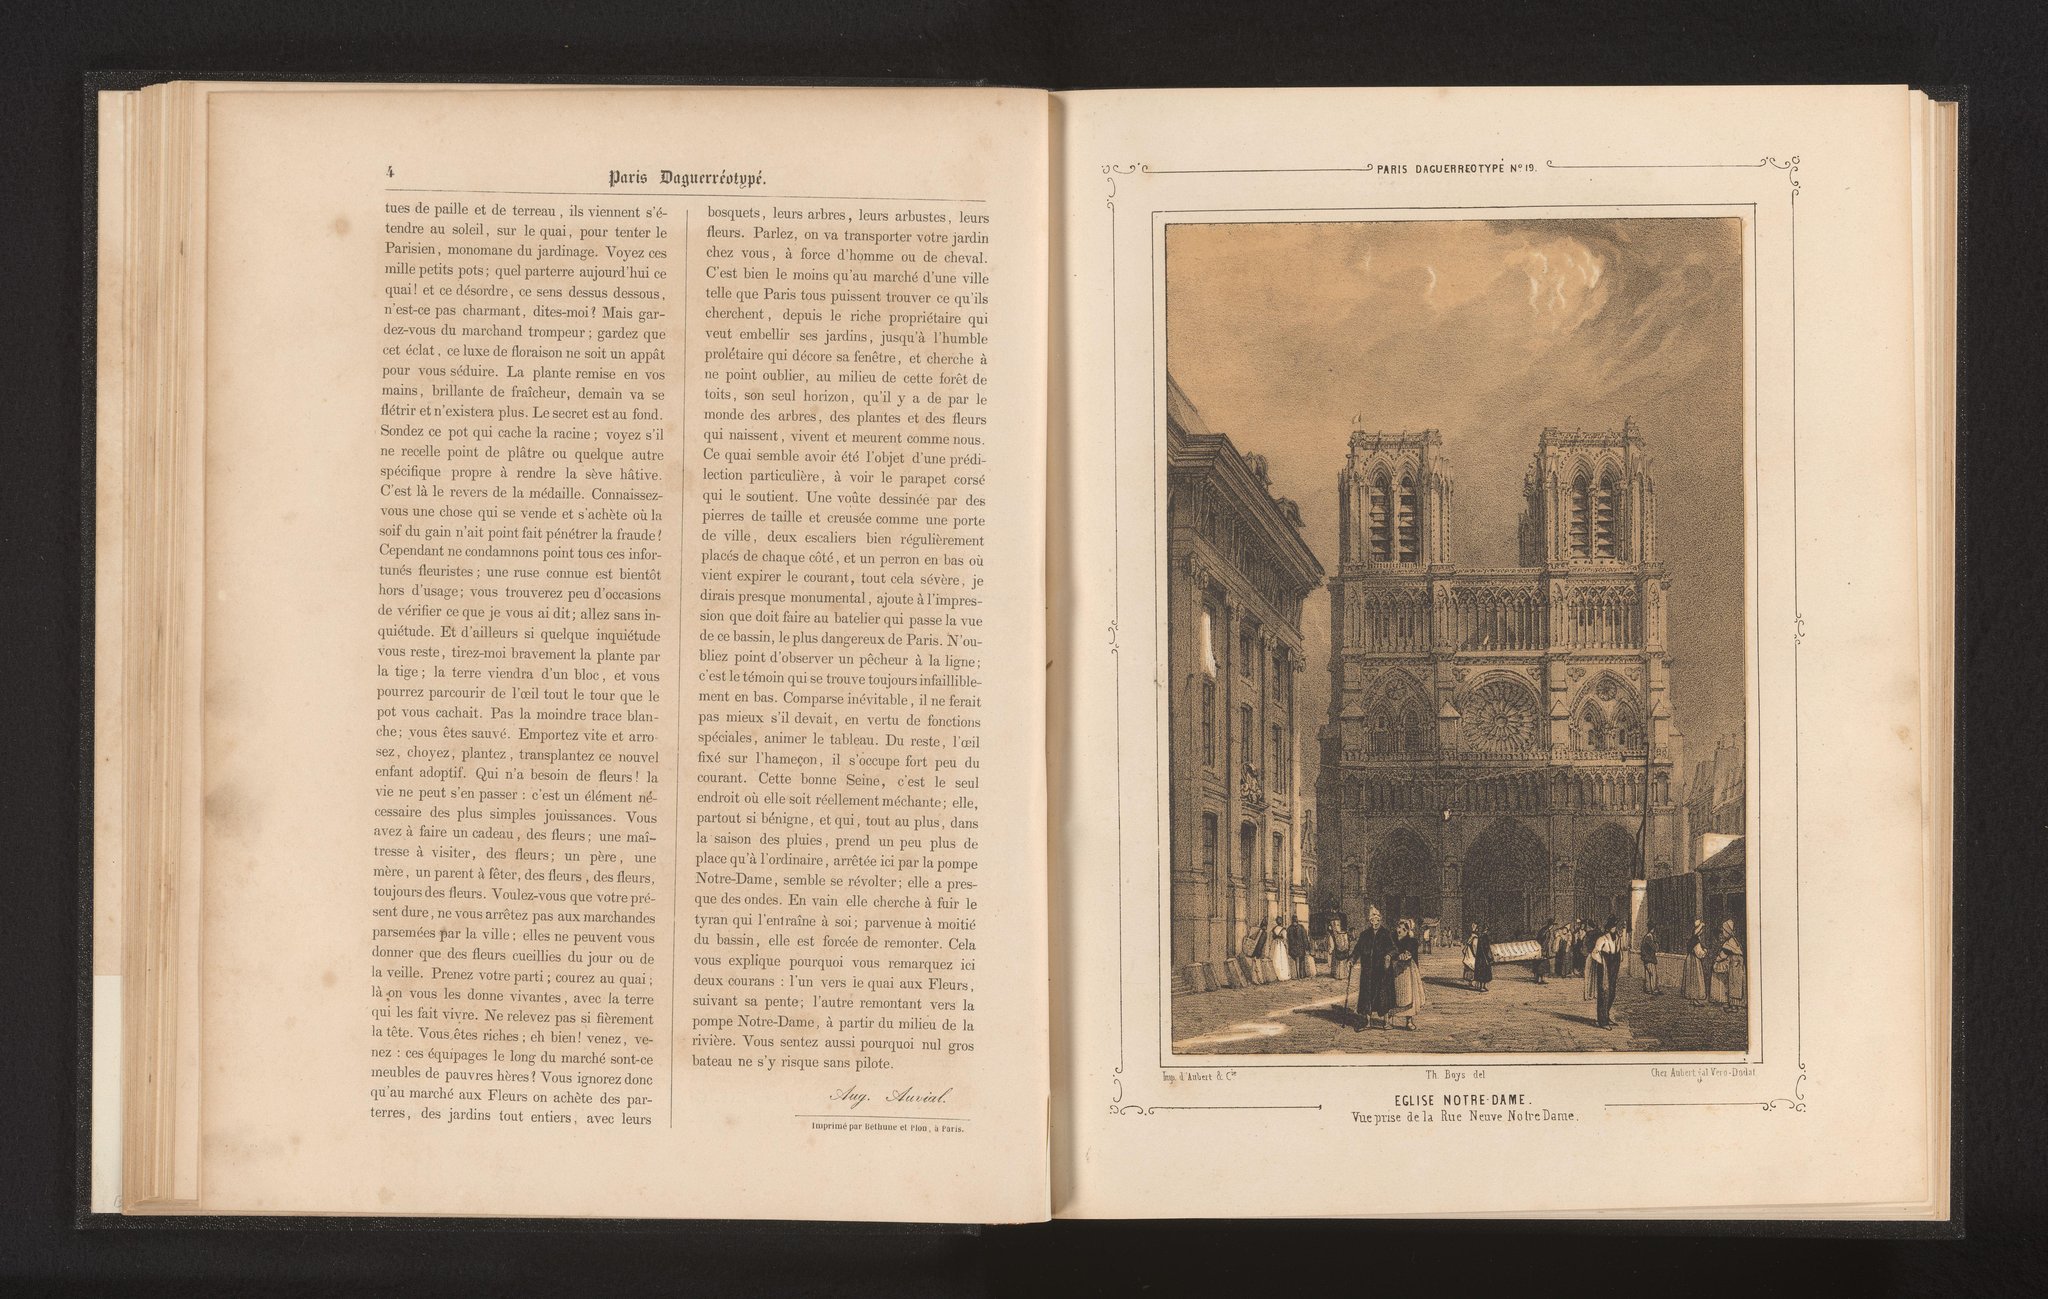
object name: page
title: Église Notre-Dame, vue prise de la Rue Neuve Notre-Dame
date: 1839-1840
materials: paper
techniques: tone lithography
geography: paris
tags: church (exterior)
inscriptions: inscription: ‘PARIS DAGUERRÉOTYPÉ No. 19.’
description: Prent op vijfenzeventigste ongenummerde pagina.